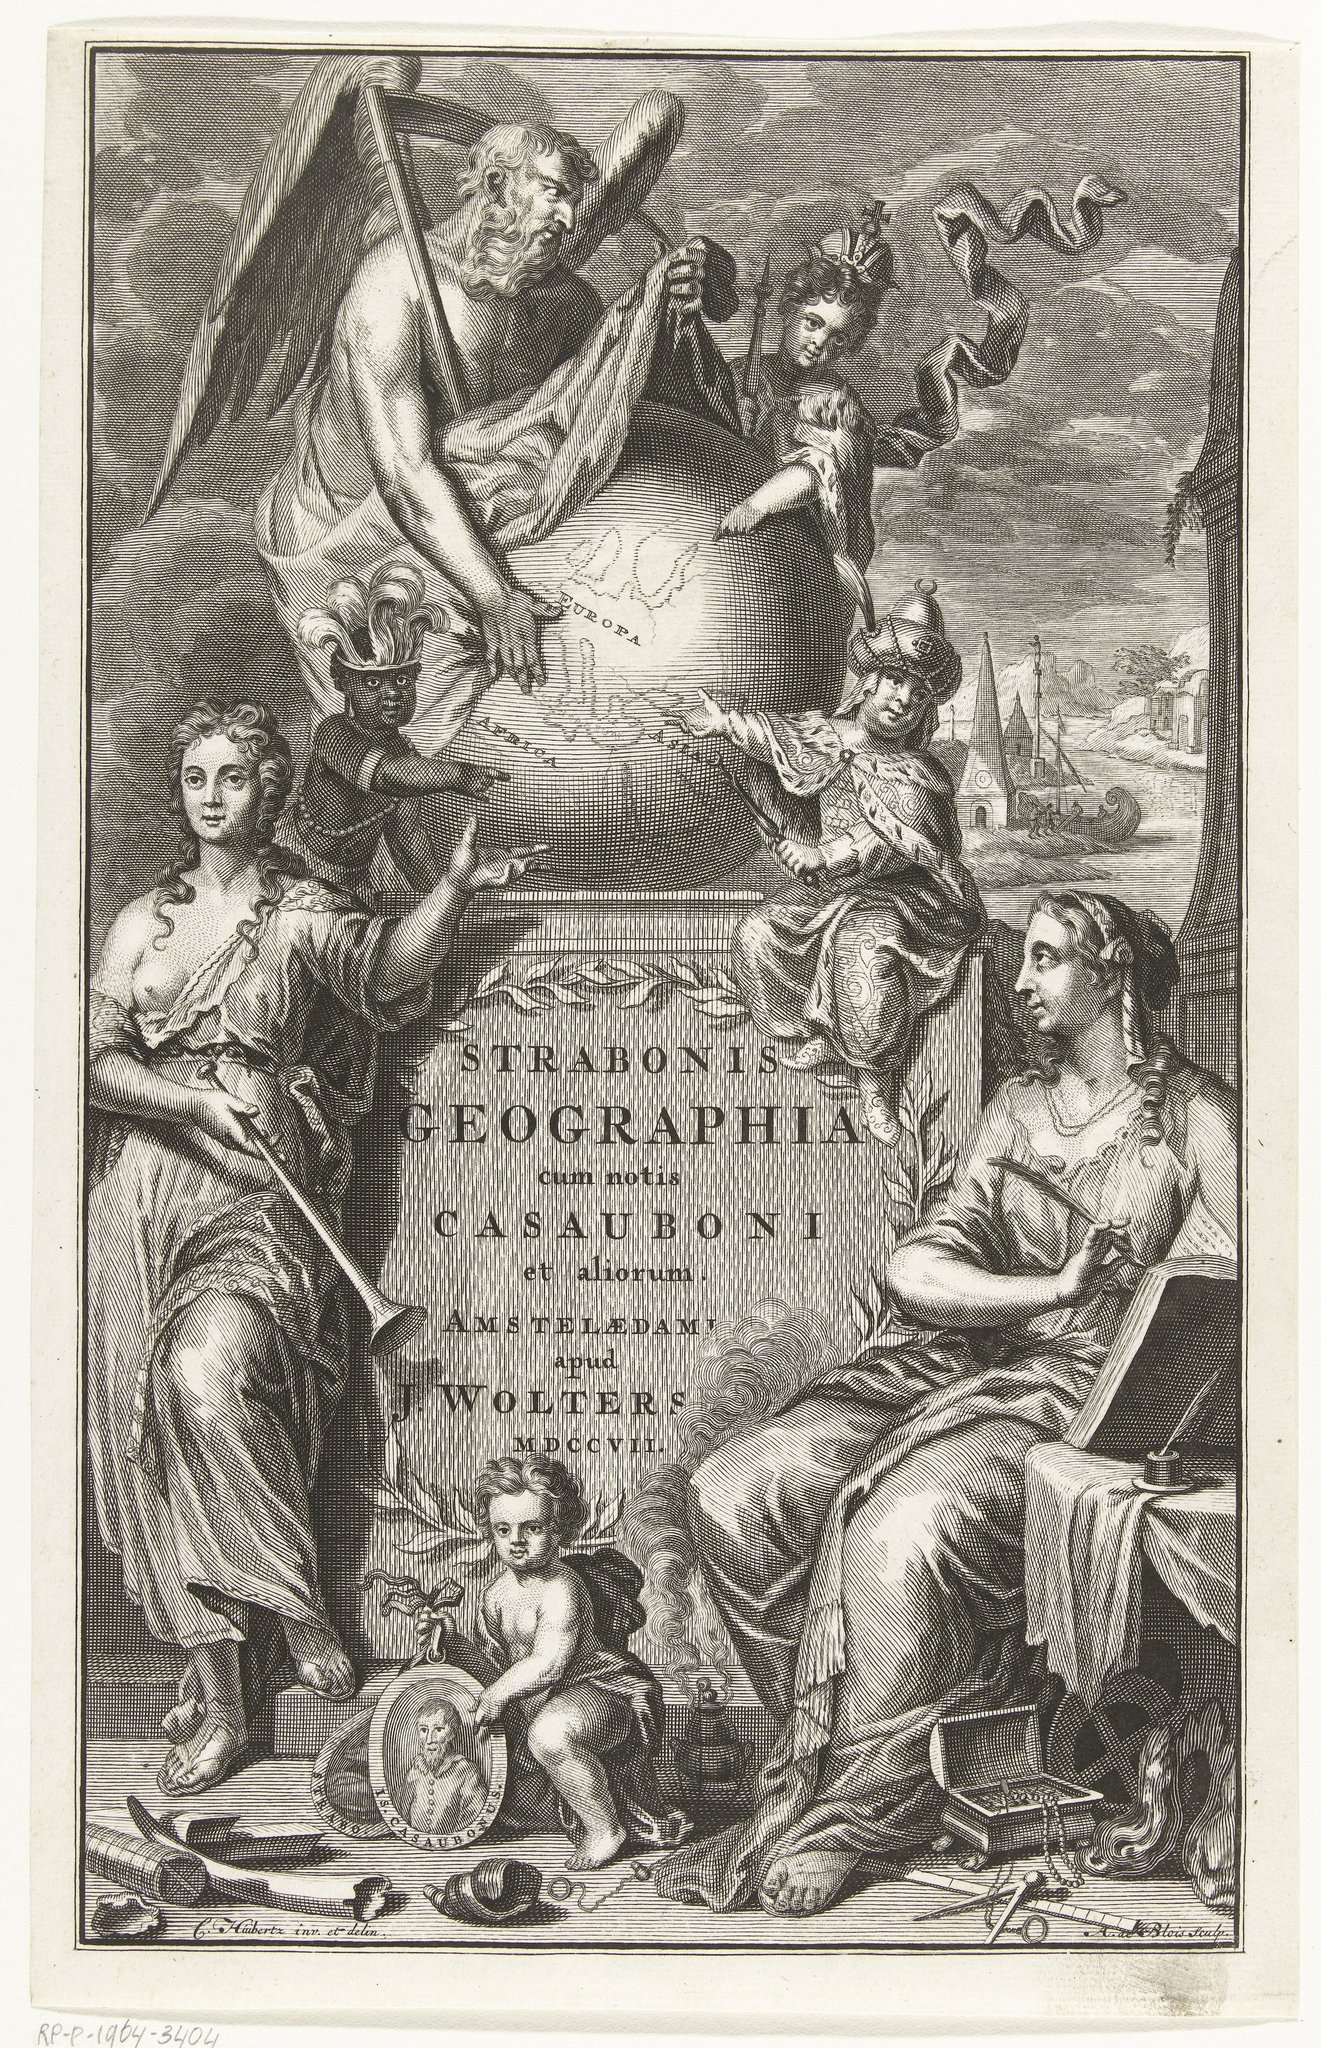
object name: print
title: Titelpagina voor: Strabo, Rerum geographicarum libri XVII, Amsterdam, 1707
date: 1679-1707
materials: paper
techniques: engraving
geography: netherlands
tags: 'geografia', 'historia'; 'historia' (ripa), globe, father time, man with wings and scythe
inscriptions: collector's mark: Lugt 2228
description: Allegorie met schrijvende vrouw als personificatie van Geschiedenis (Historia) en Vader Tijd met wereldbol. Roem staand met trompet naast de sokkel met de titel wijzend naar de globe. Drie kinderen staan voor de drie werelddelen Europa, Afrika en Azië.